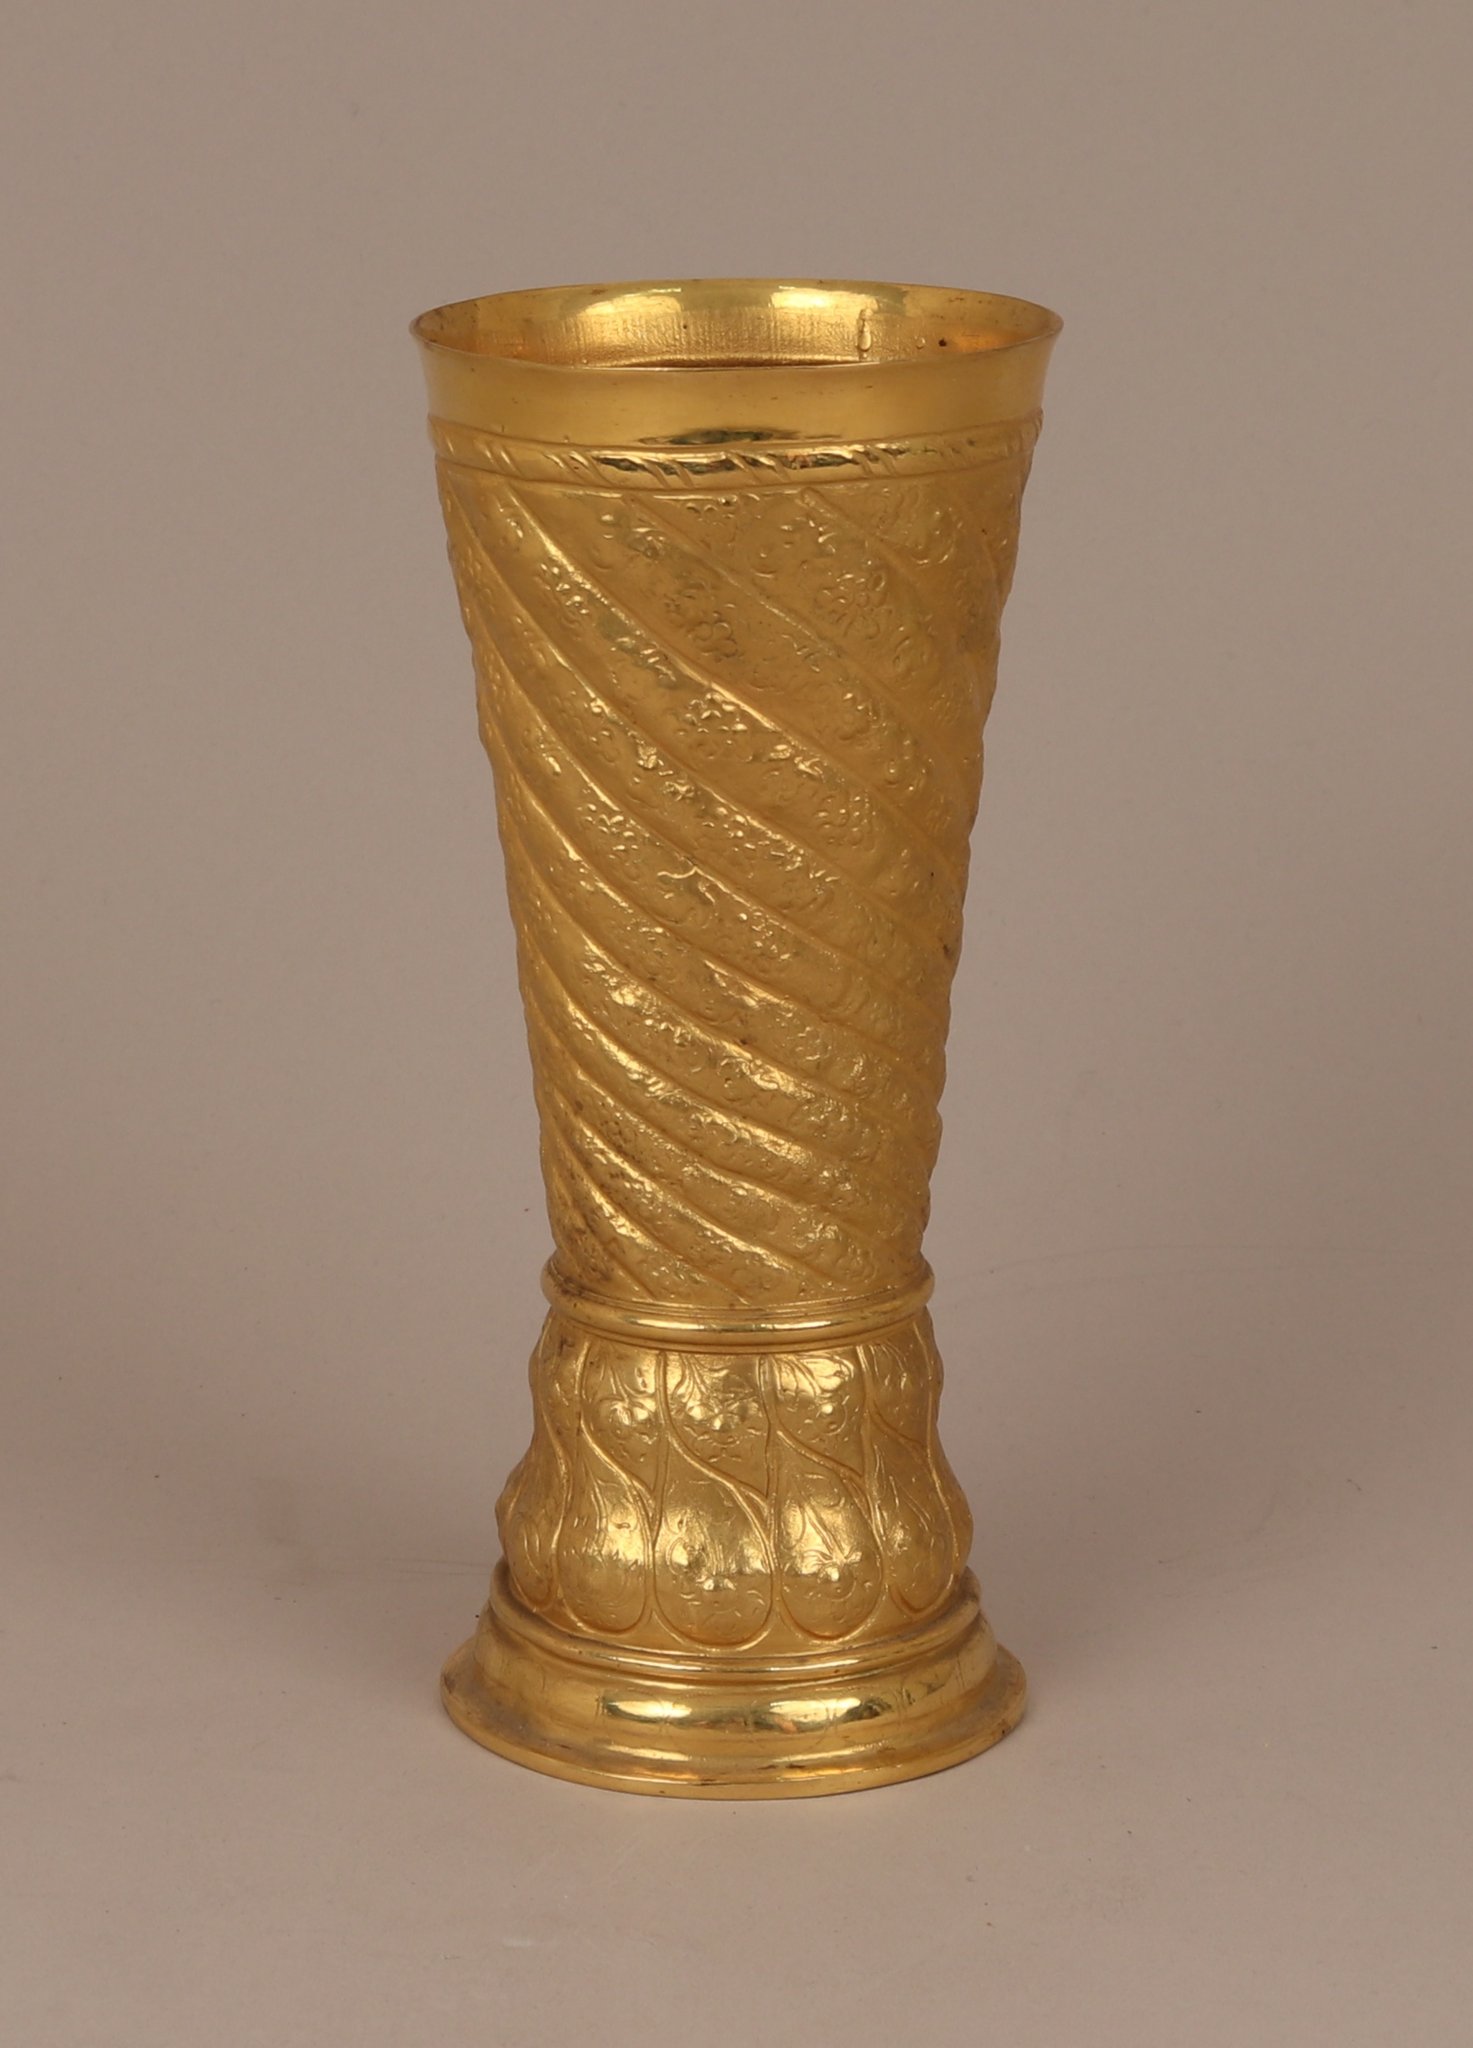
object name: beaker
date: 1801-1900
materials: metal, silver